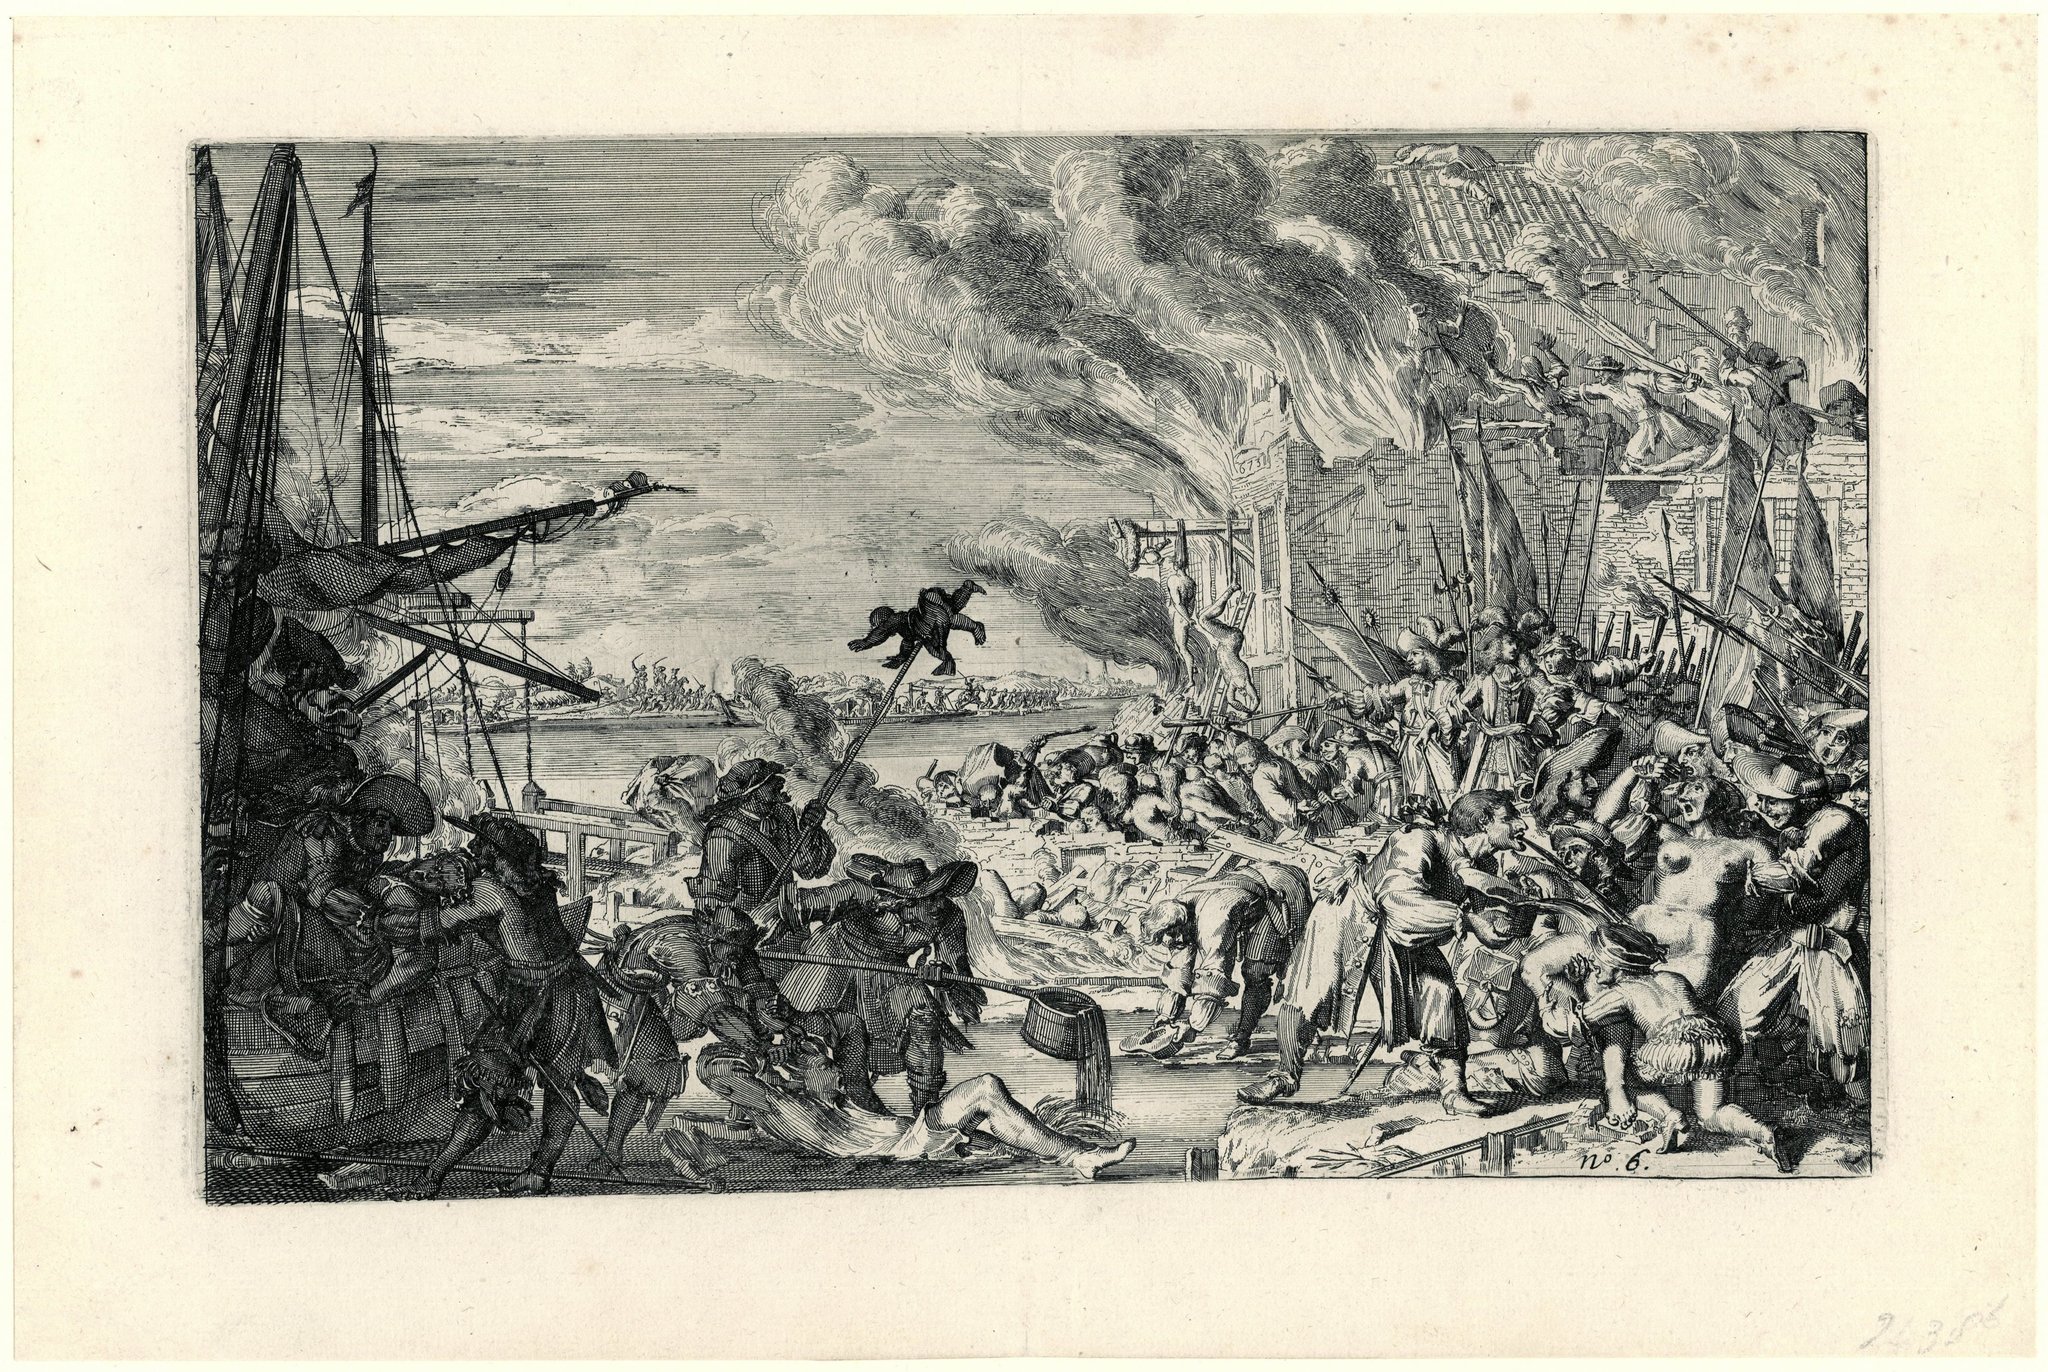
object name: print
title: Wreedheden in een dorp aan het water, 1672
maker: Anonymous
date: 1673-1675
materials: paper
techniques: engraving, etching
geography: northern netherlands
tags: rape, violation, violent death, being killed; being mishandled and maltreated; seeking death, massacre ~ war, bodegraven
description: Prent ook gebruikt in: Bosch, Lambert van den. Toneel des oorlogs, opgerecht in de Vereenigde Nederlanden; door de wapenen van de koningen van Vrankrijk en Engeland, Keulsche en Munstersche […]. 4 delen. Amsterdam: Jacob van Meurs en Johannes van Someren, 1675, dl. 3, p. 128. In tegenstelling tot de andere prenten in deze reeks is deze voorstelling niet opgenomen in: Valckenier, Peter en Andreas Muller. Das verwirrte Europa […]. 3 delen. Amsterdam: Hendrik en Dirk Boom, Joannes van Someren en Jacob van Meurs, 1677-1683, dl. 1 (1677). Deze prent is gekopieerd naar een prent van Romeyn de Hooghe (RP-P-OB-77.198). Die prent is gebruikt in: Wicquefort, Abraham van. Avis fidelle aux veritables hollandois. Touchant ce qui s’est passé dans les villages de Bodegrave & Swammerdam, & les cruautés inoüies, que les françois y ont exercées […]. S.l. [Den Haag]: s.n.[Daniel en Johannes Steucker], 1673.